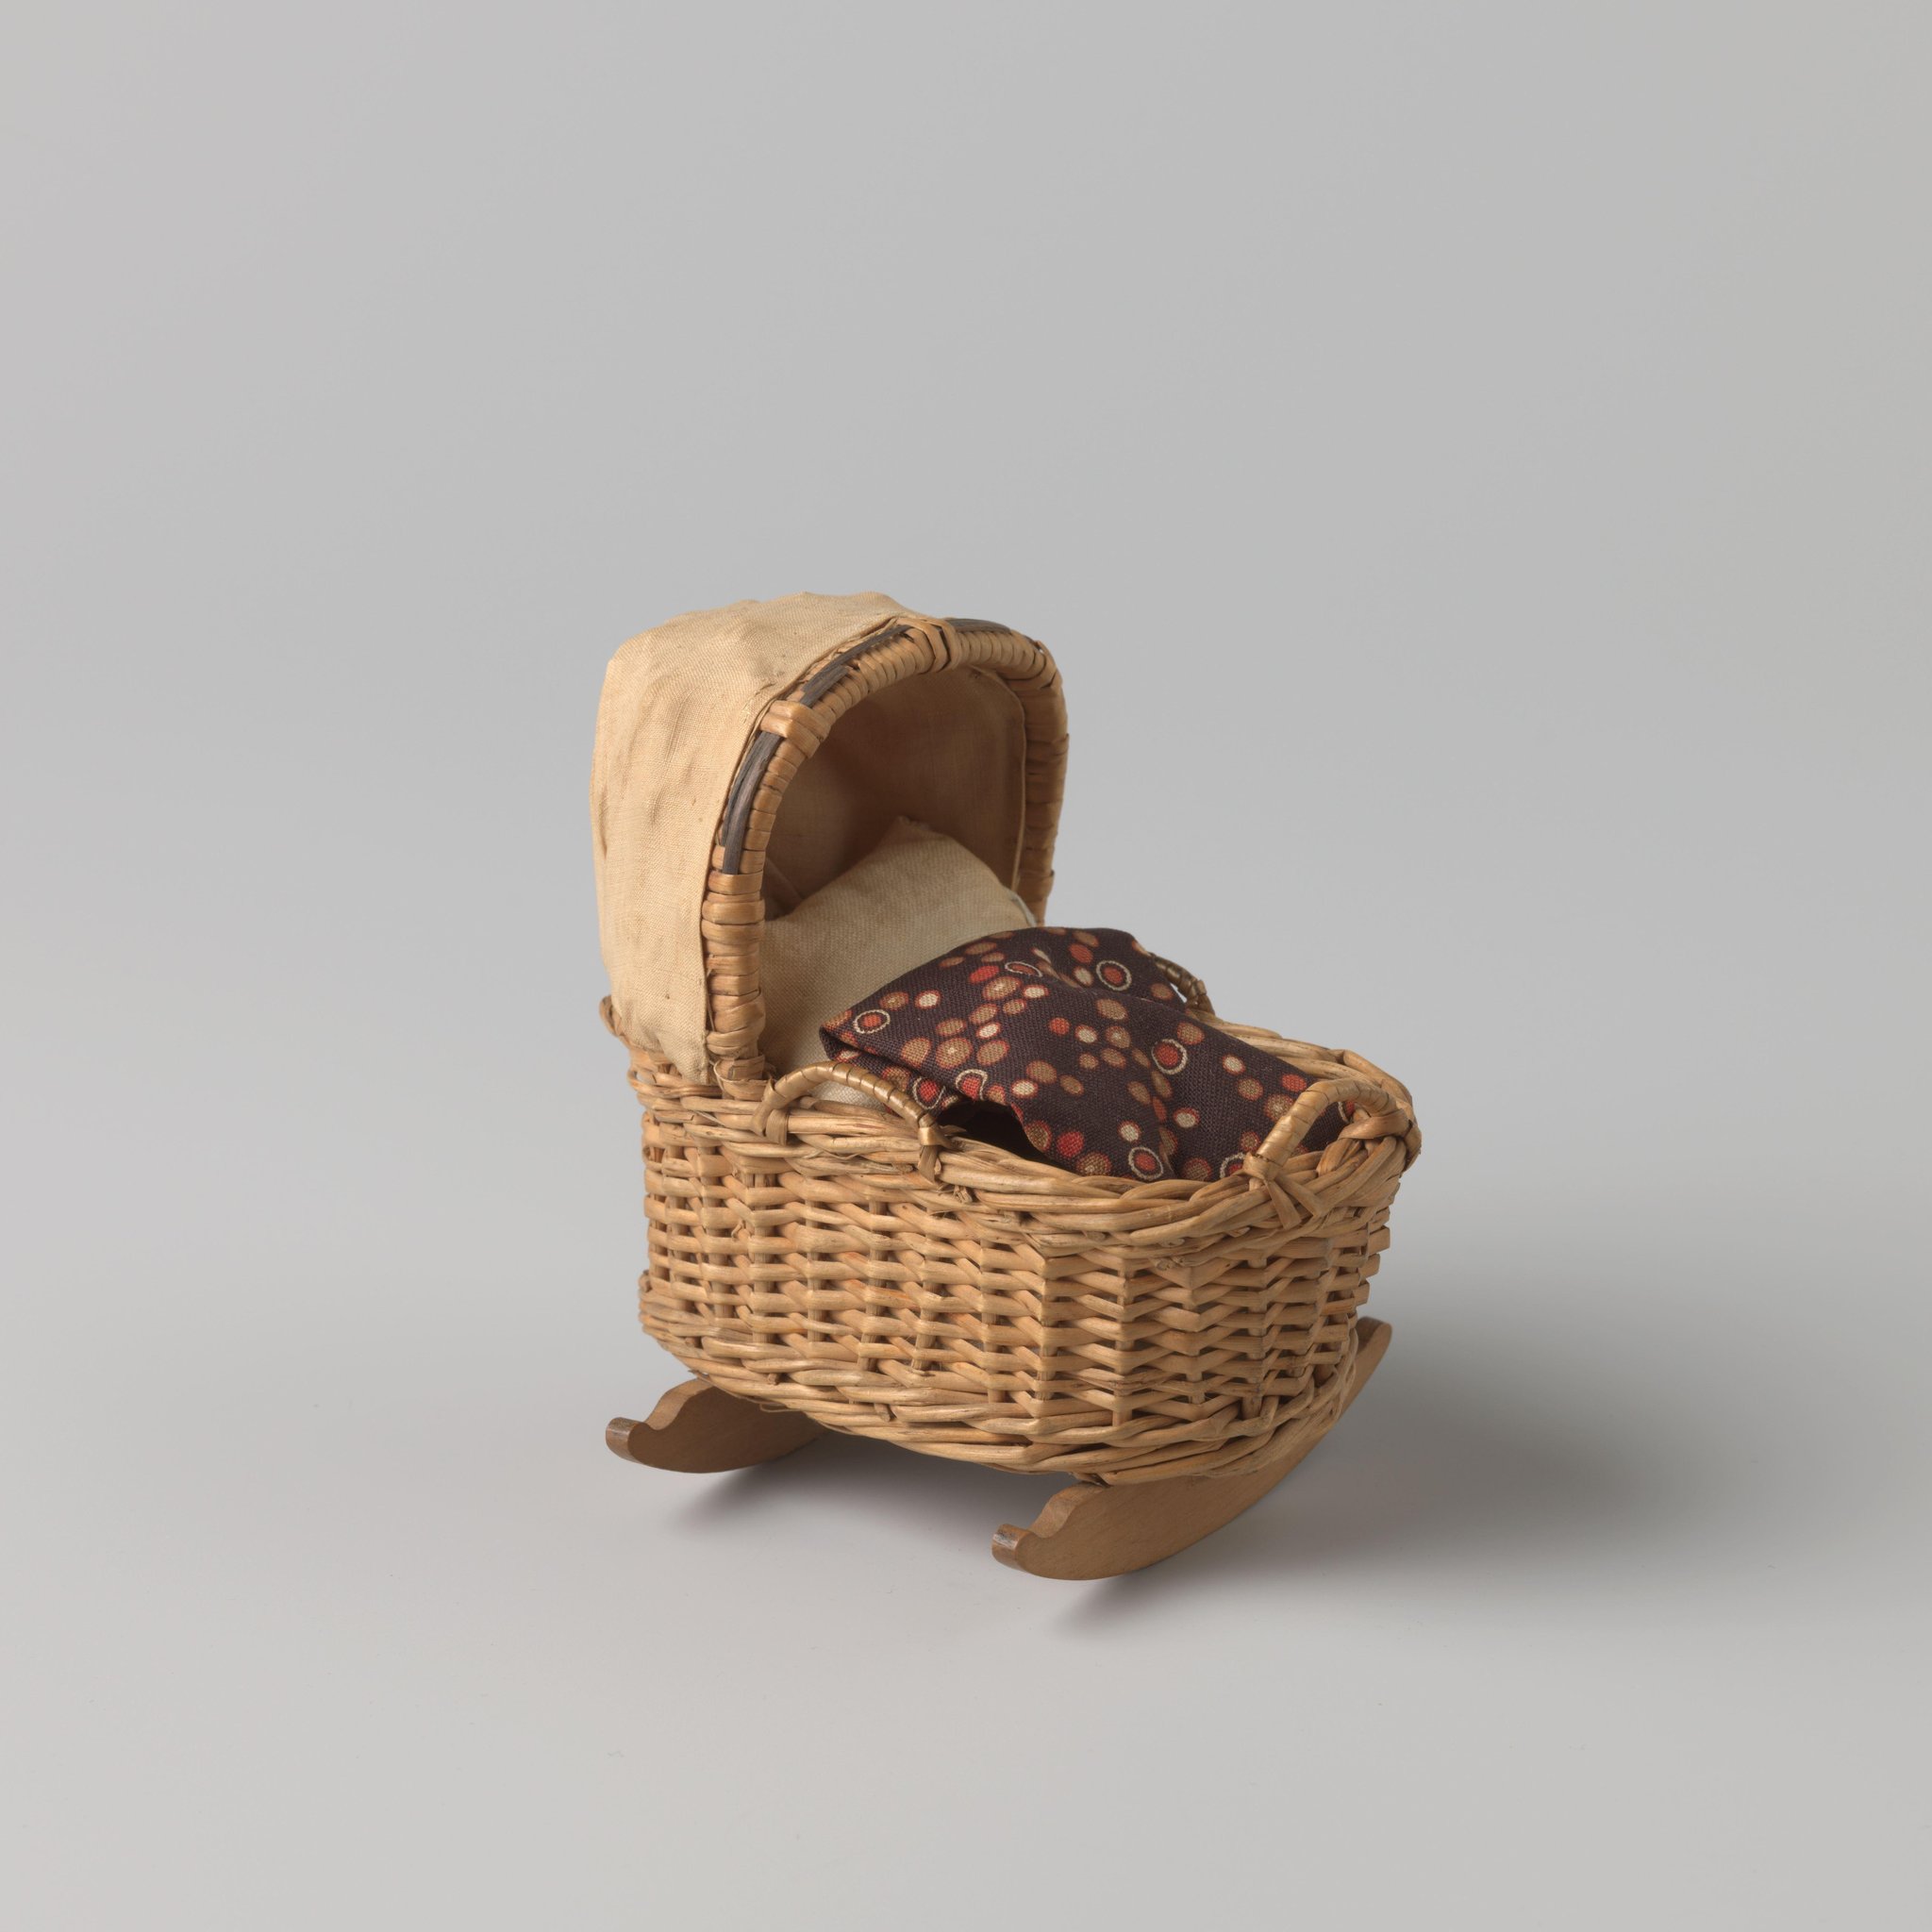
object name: miniature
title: Matras van witte katoen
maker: Anonymous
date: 1750-1800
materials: cotton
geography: amsterdam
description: Matras uit de wieg, vervaardigd van witte katoen, gevuld met pluis.